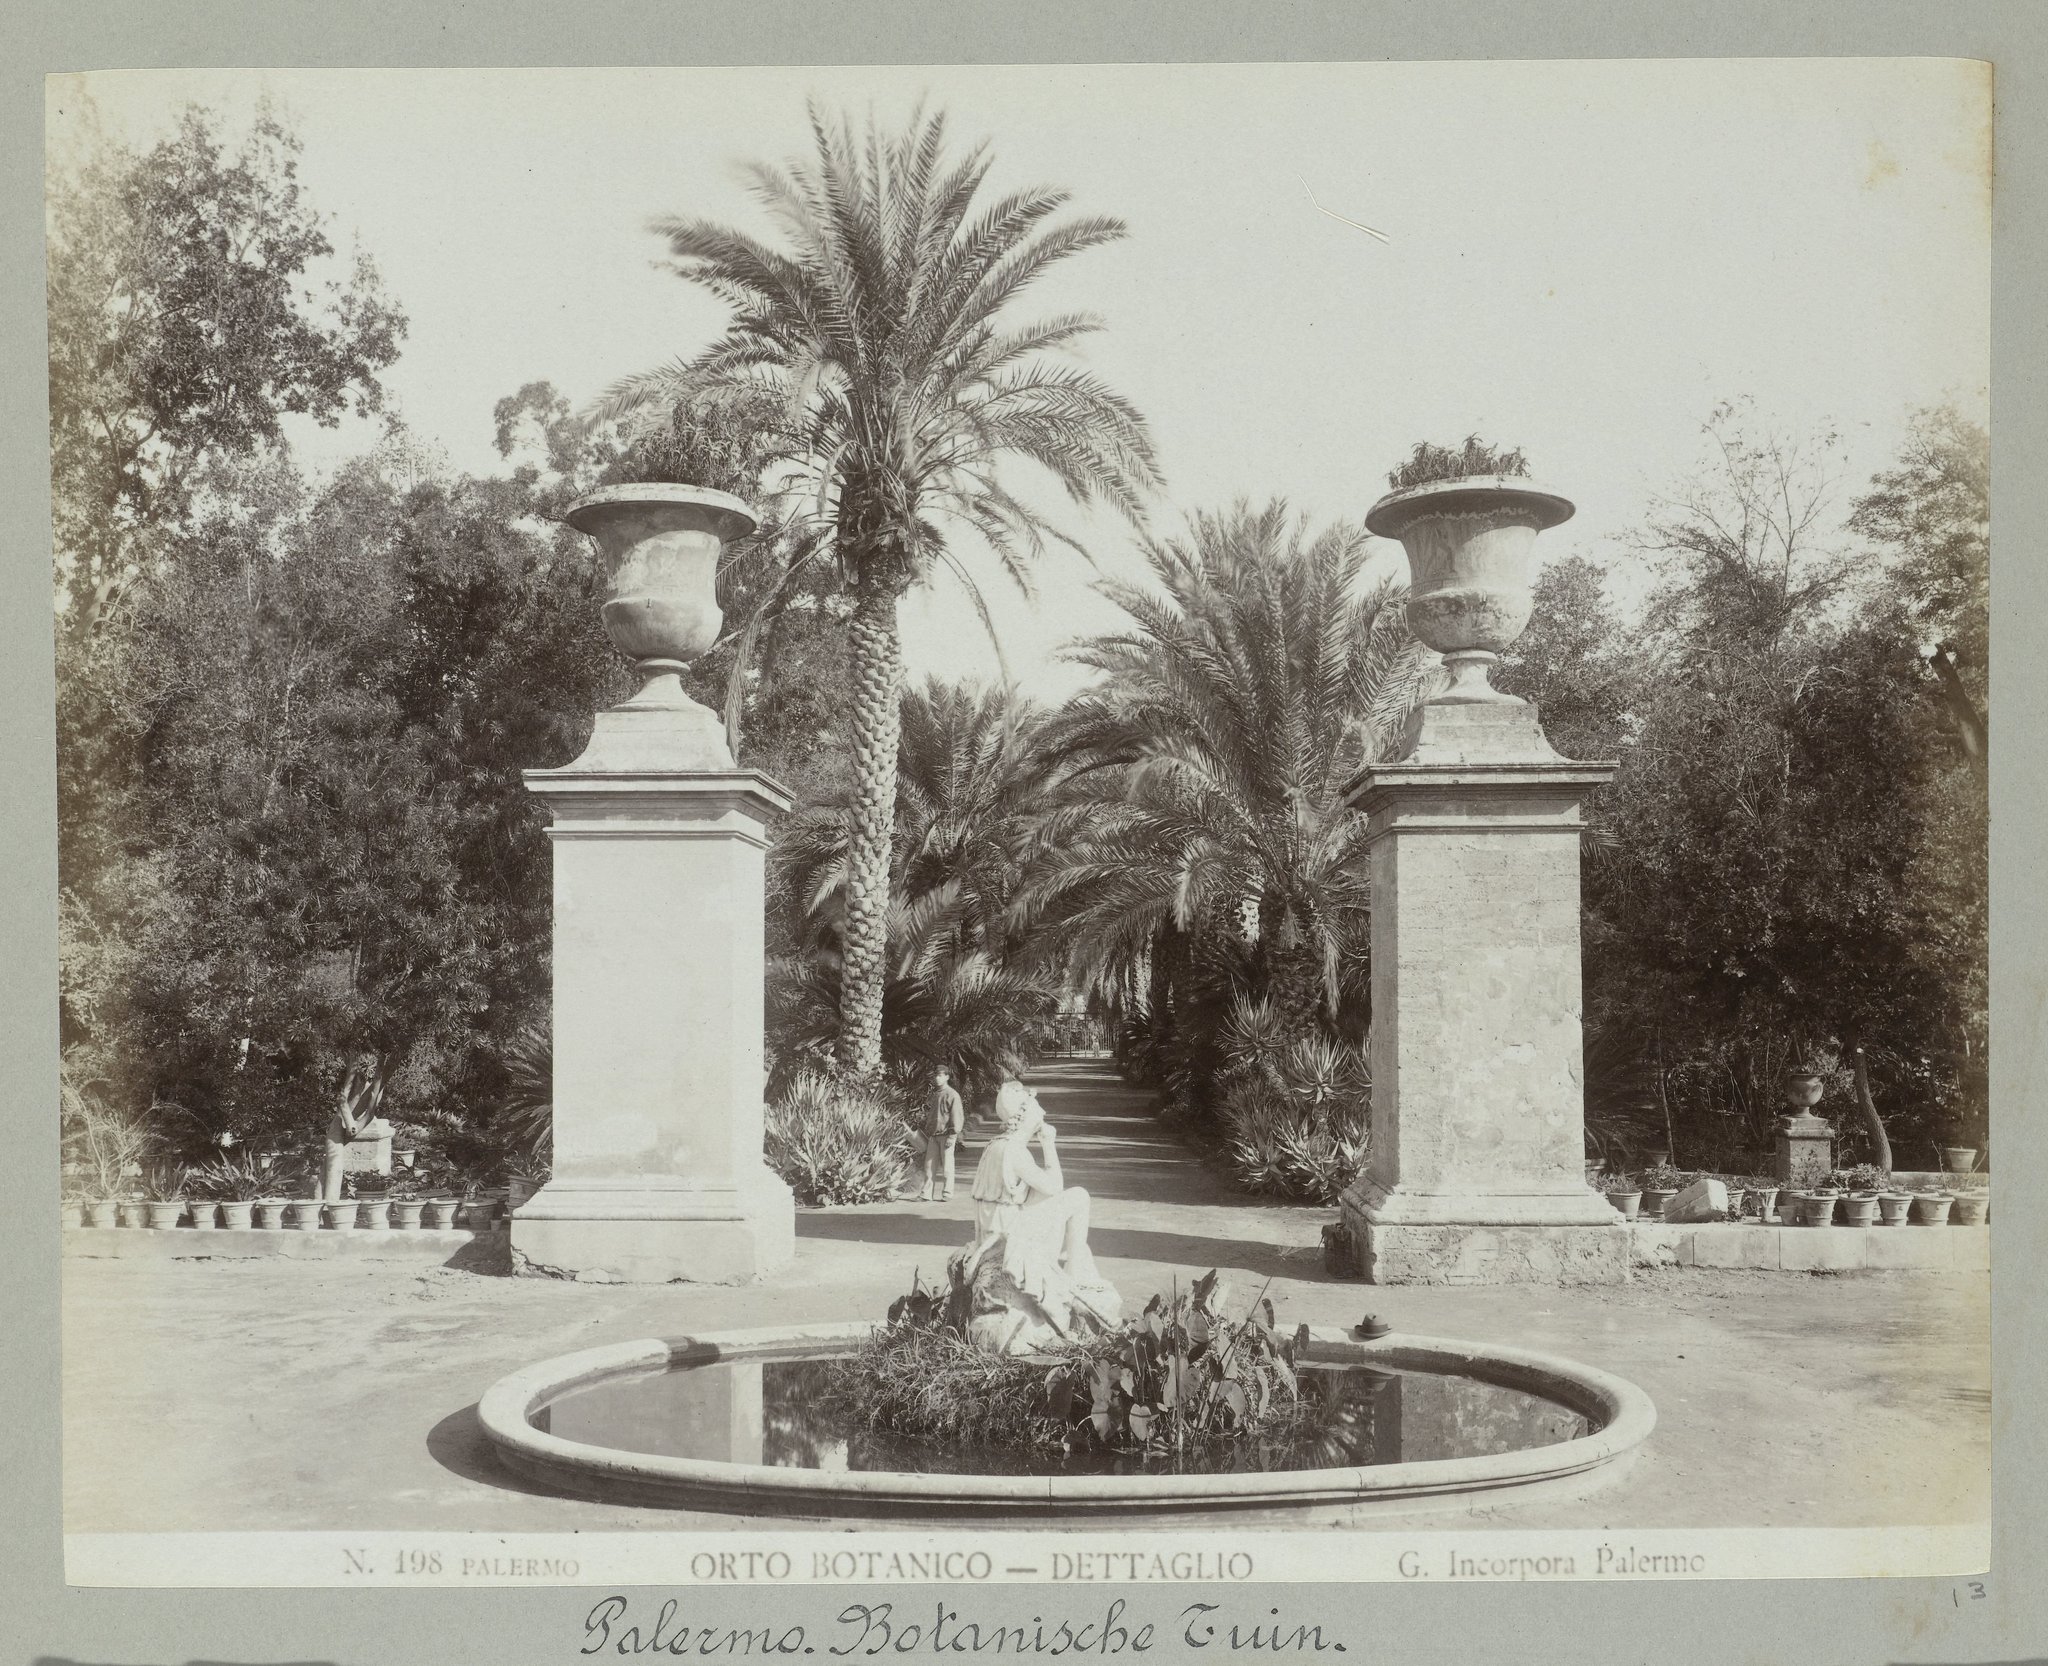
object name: photograph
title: N. 198 Palermo, Orto Botanico - Dettaglio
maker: giuseppe incorpora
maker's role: fotograaf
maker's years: 1834-1914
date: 1893-1903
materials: cardboard, photographic support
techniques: albumen print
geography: netherlands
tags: palermo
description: Een vijver in de botanische tuin van Palermo.